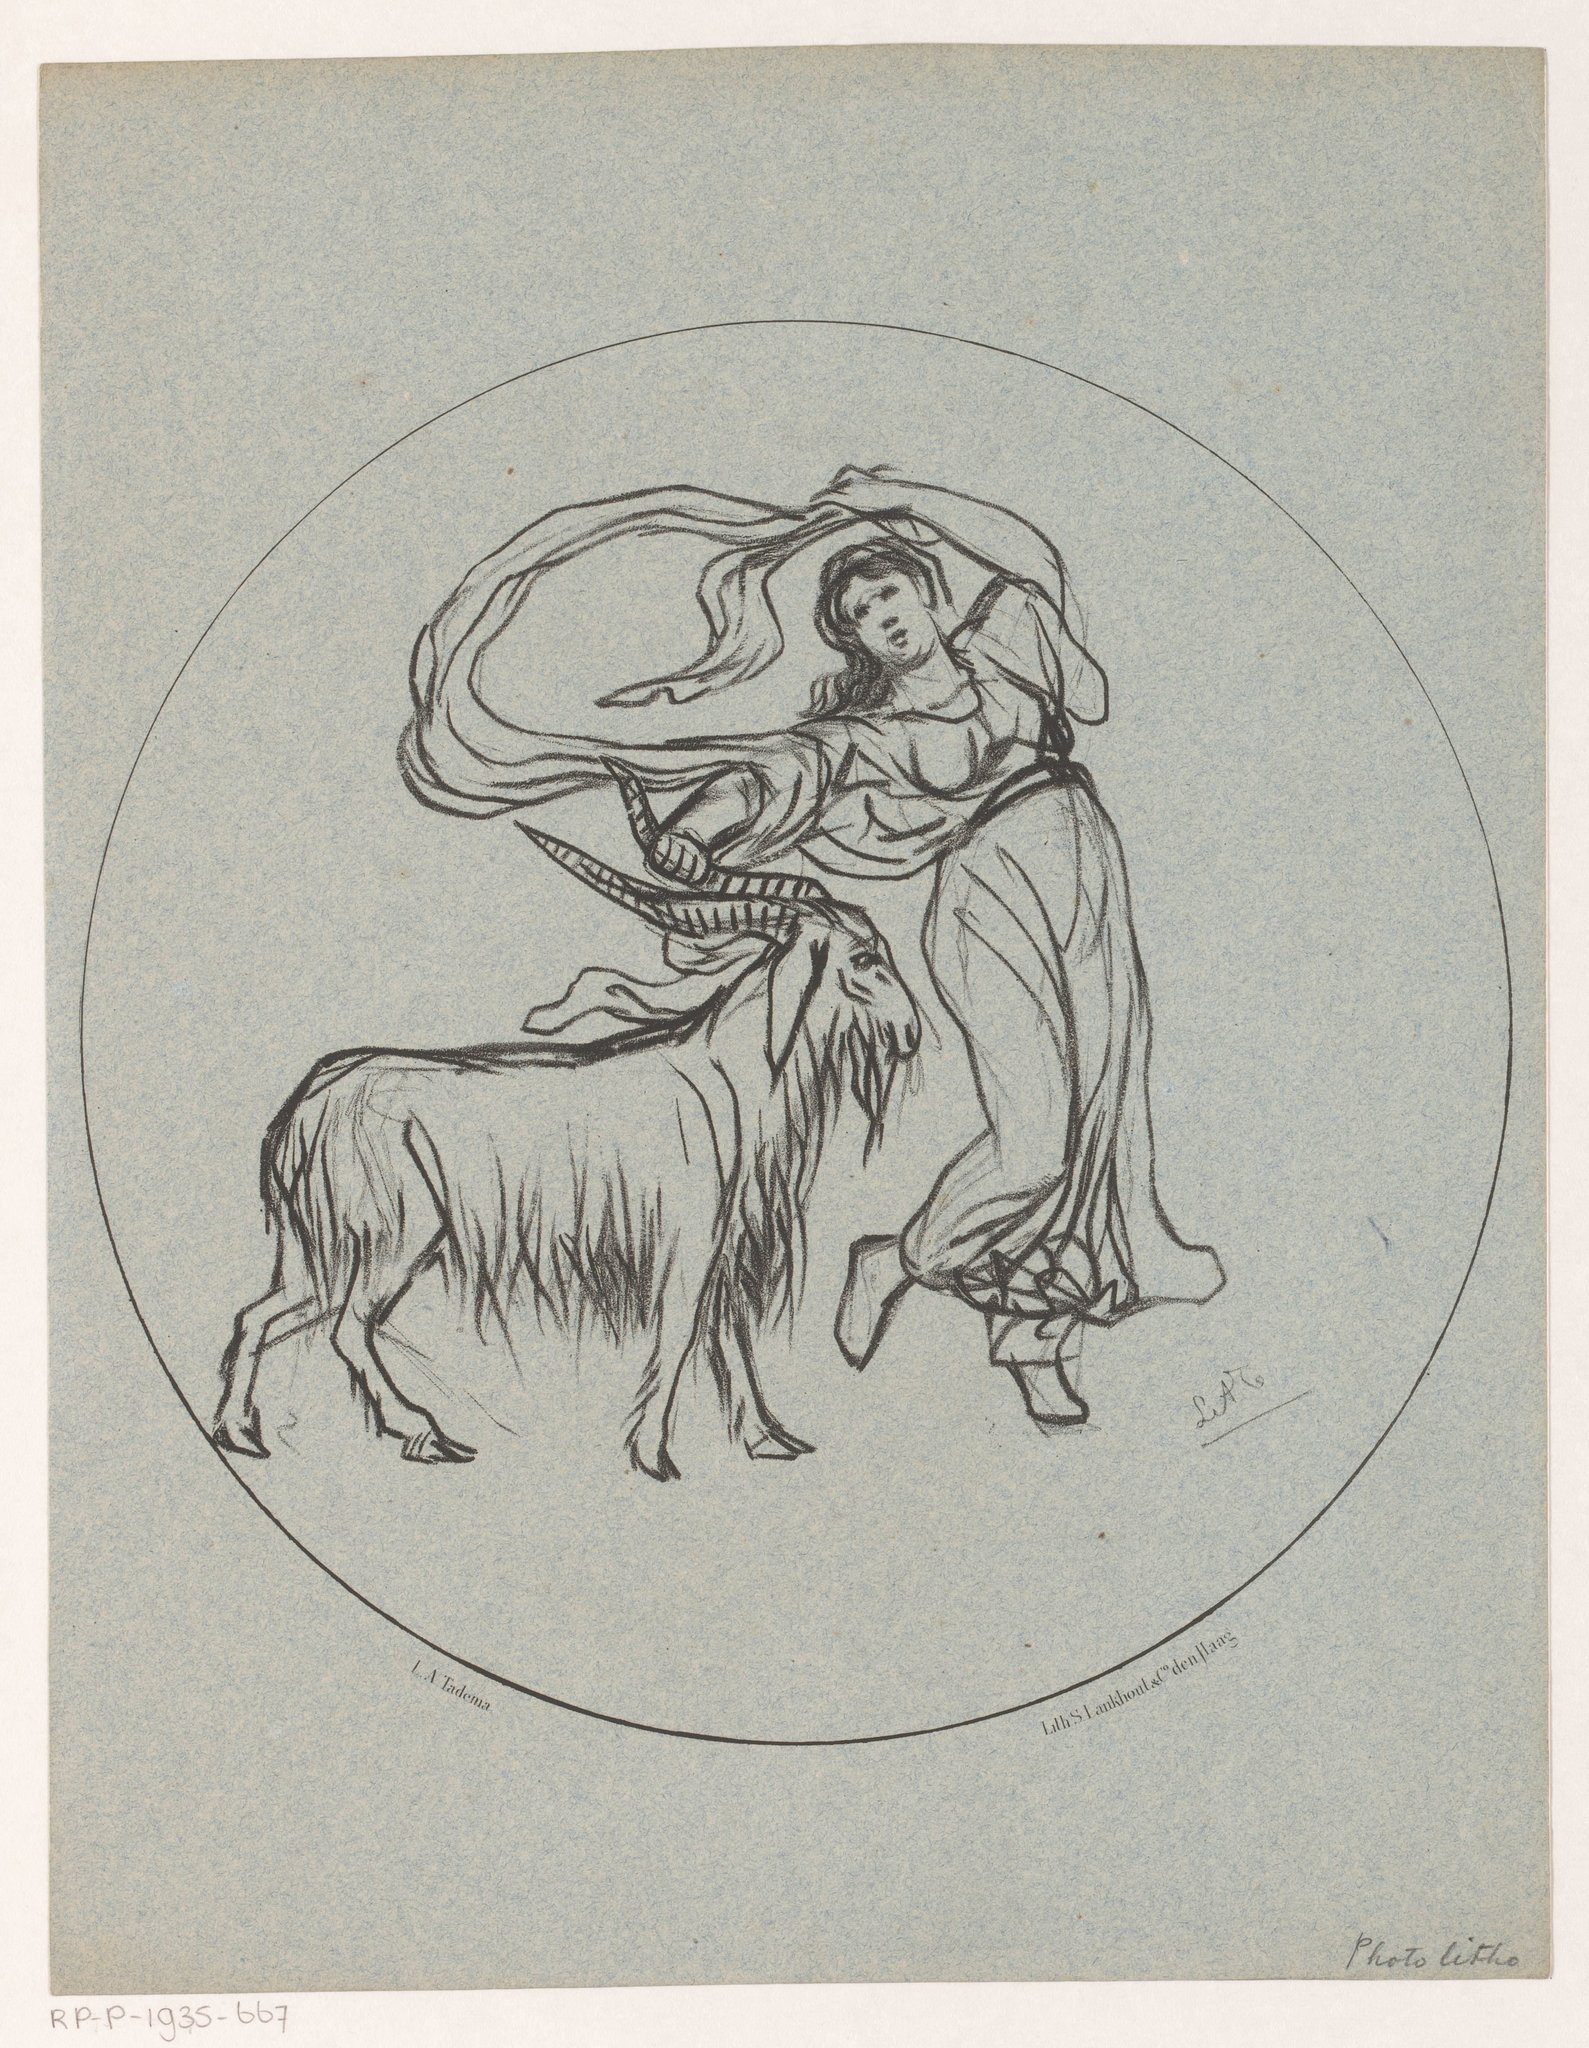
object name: print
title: Vrouw en geit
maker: lourens alma tadema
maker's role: draughtsman, print maker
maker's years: 1836-1912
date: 1877-1903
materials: paper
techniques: photolithography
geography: the hague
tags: goat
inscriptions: collector's mark: Lugt 2228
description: Een vrouw met doek in haar handen grijpt een geit bij zijn hoorn.